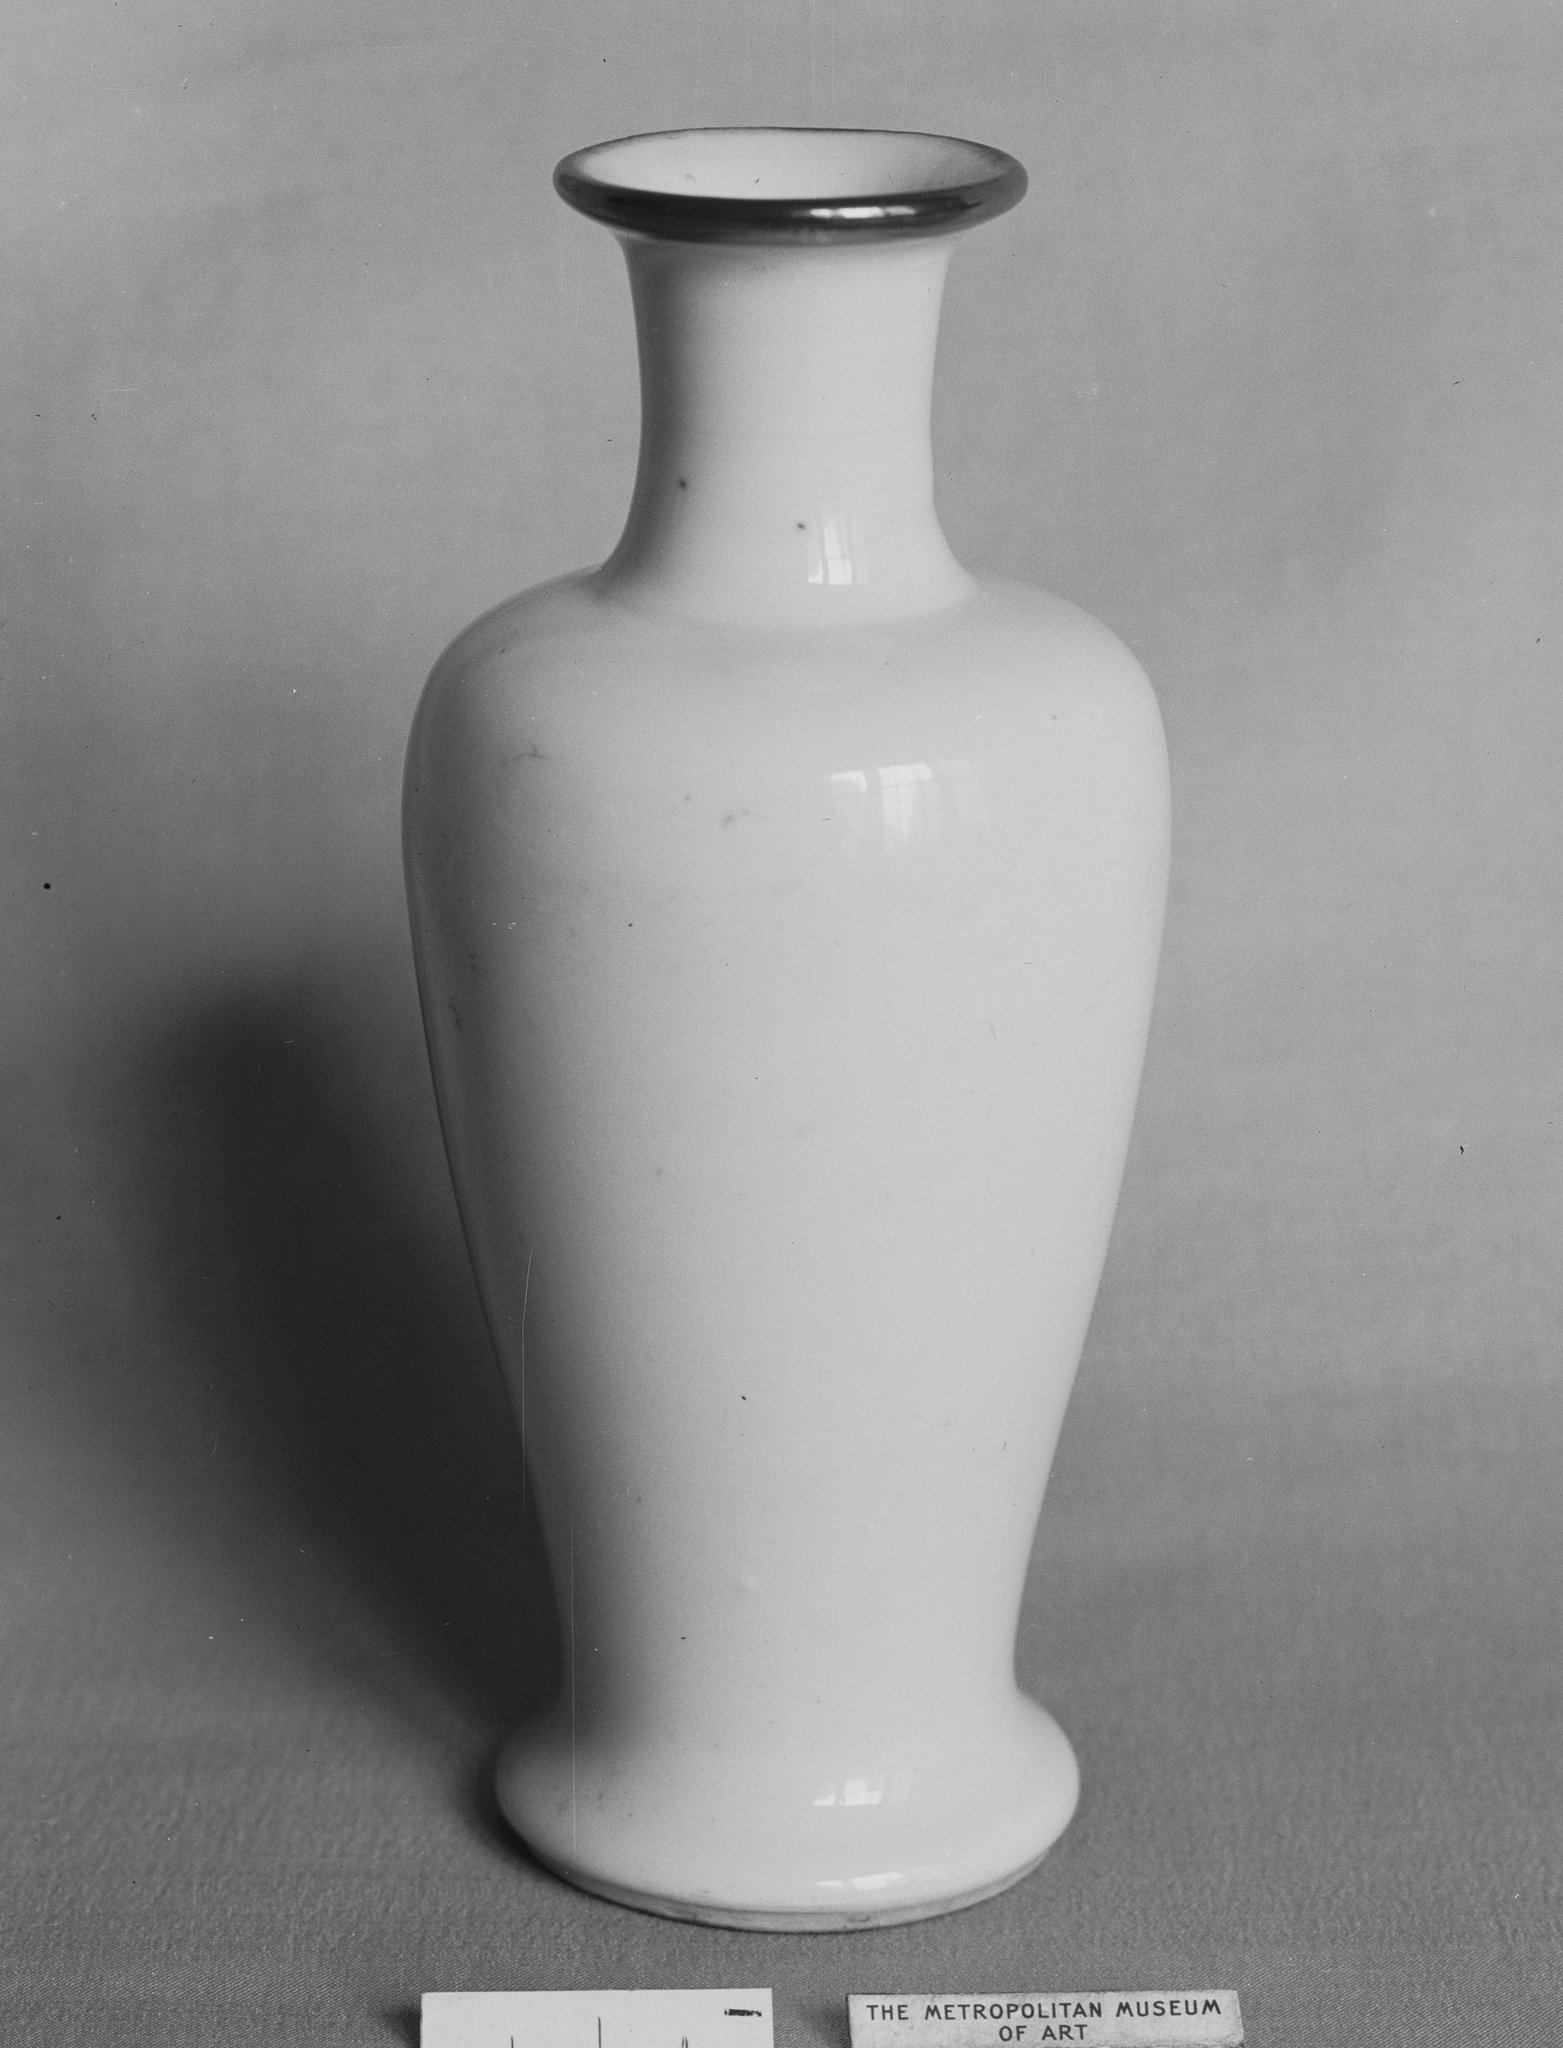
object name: vase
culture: chinese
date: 1662-1722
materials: porcelain